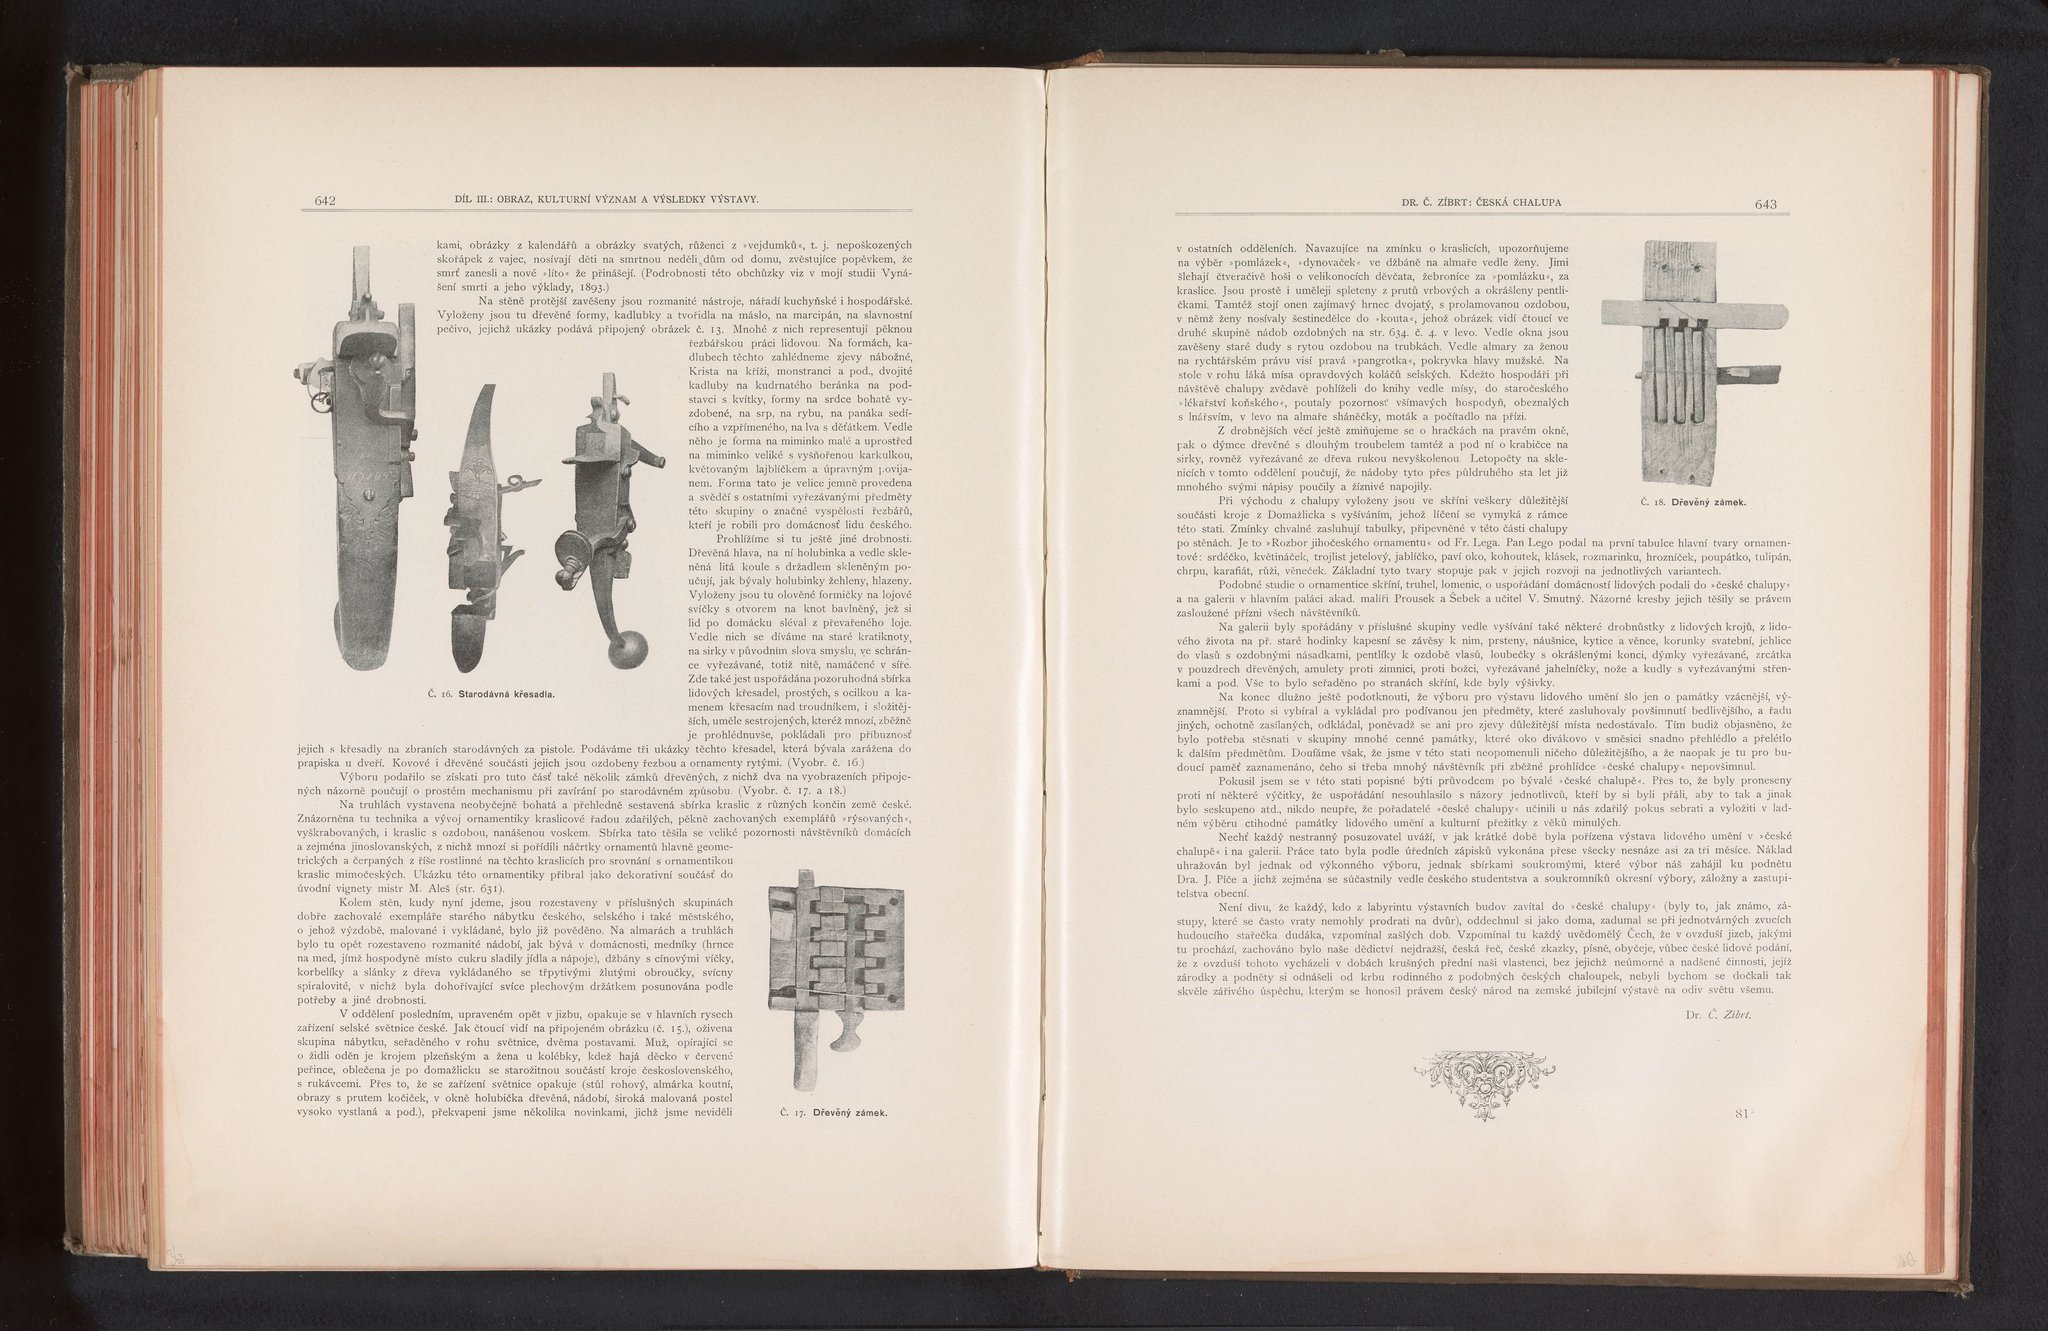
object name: photomechanical print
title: Tondeldoos en een houten slot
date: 1891-1895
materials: paper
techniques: autotype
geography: prague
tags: lock ~ door, tinder-box